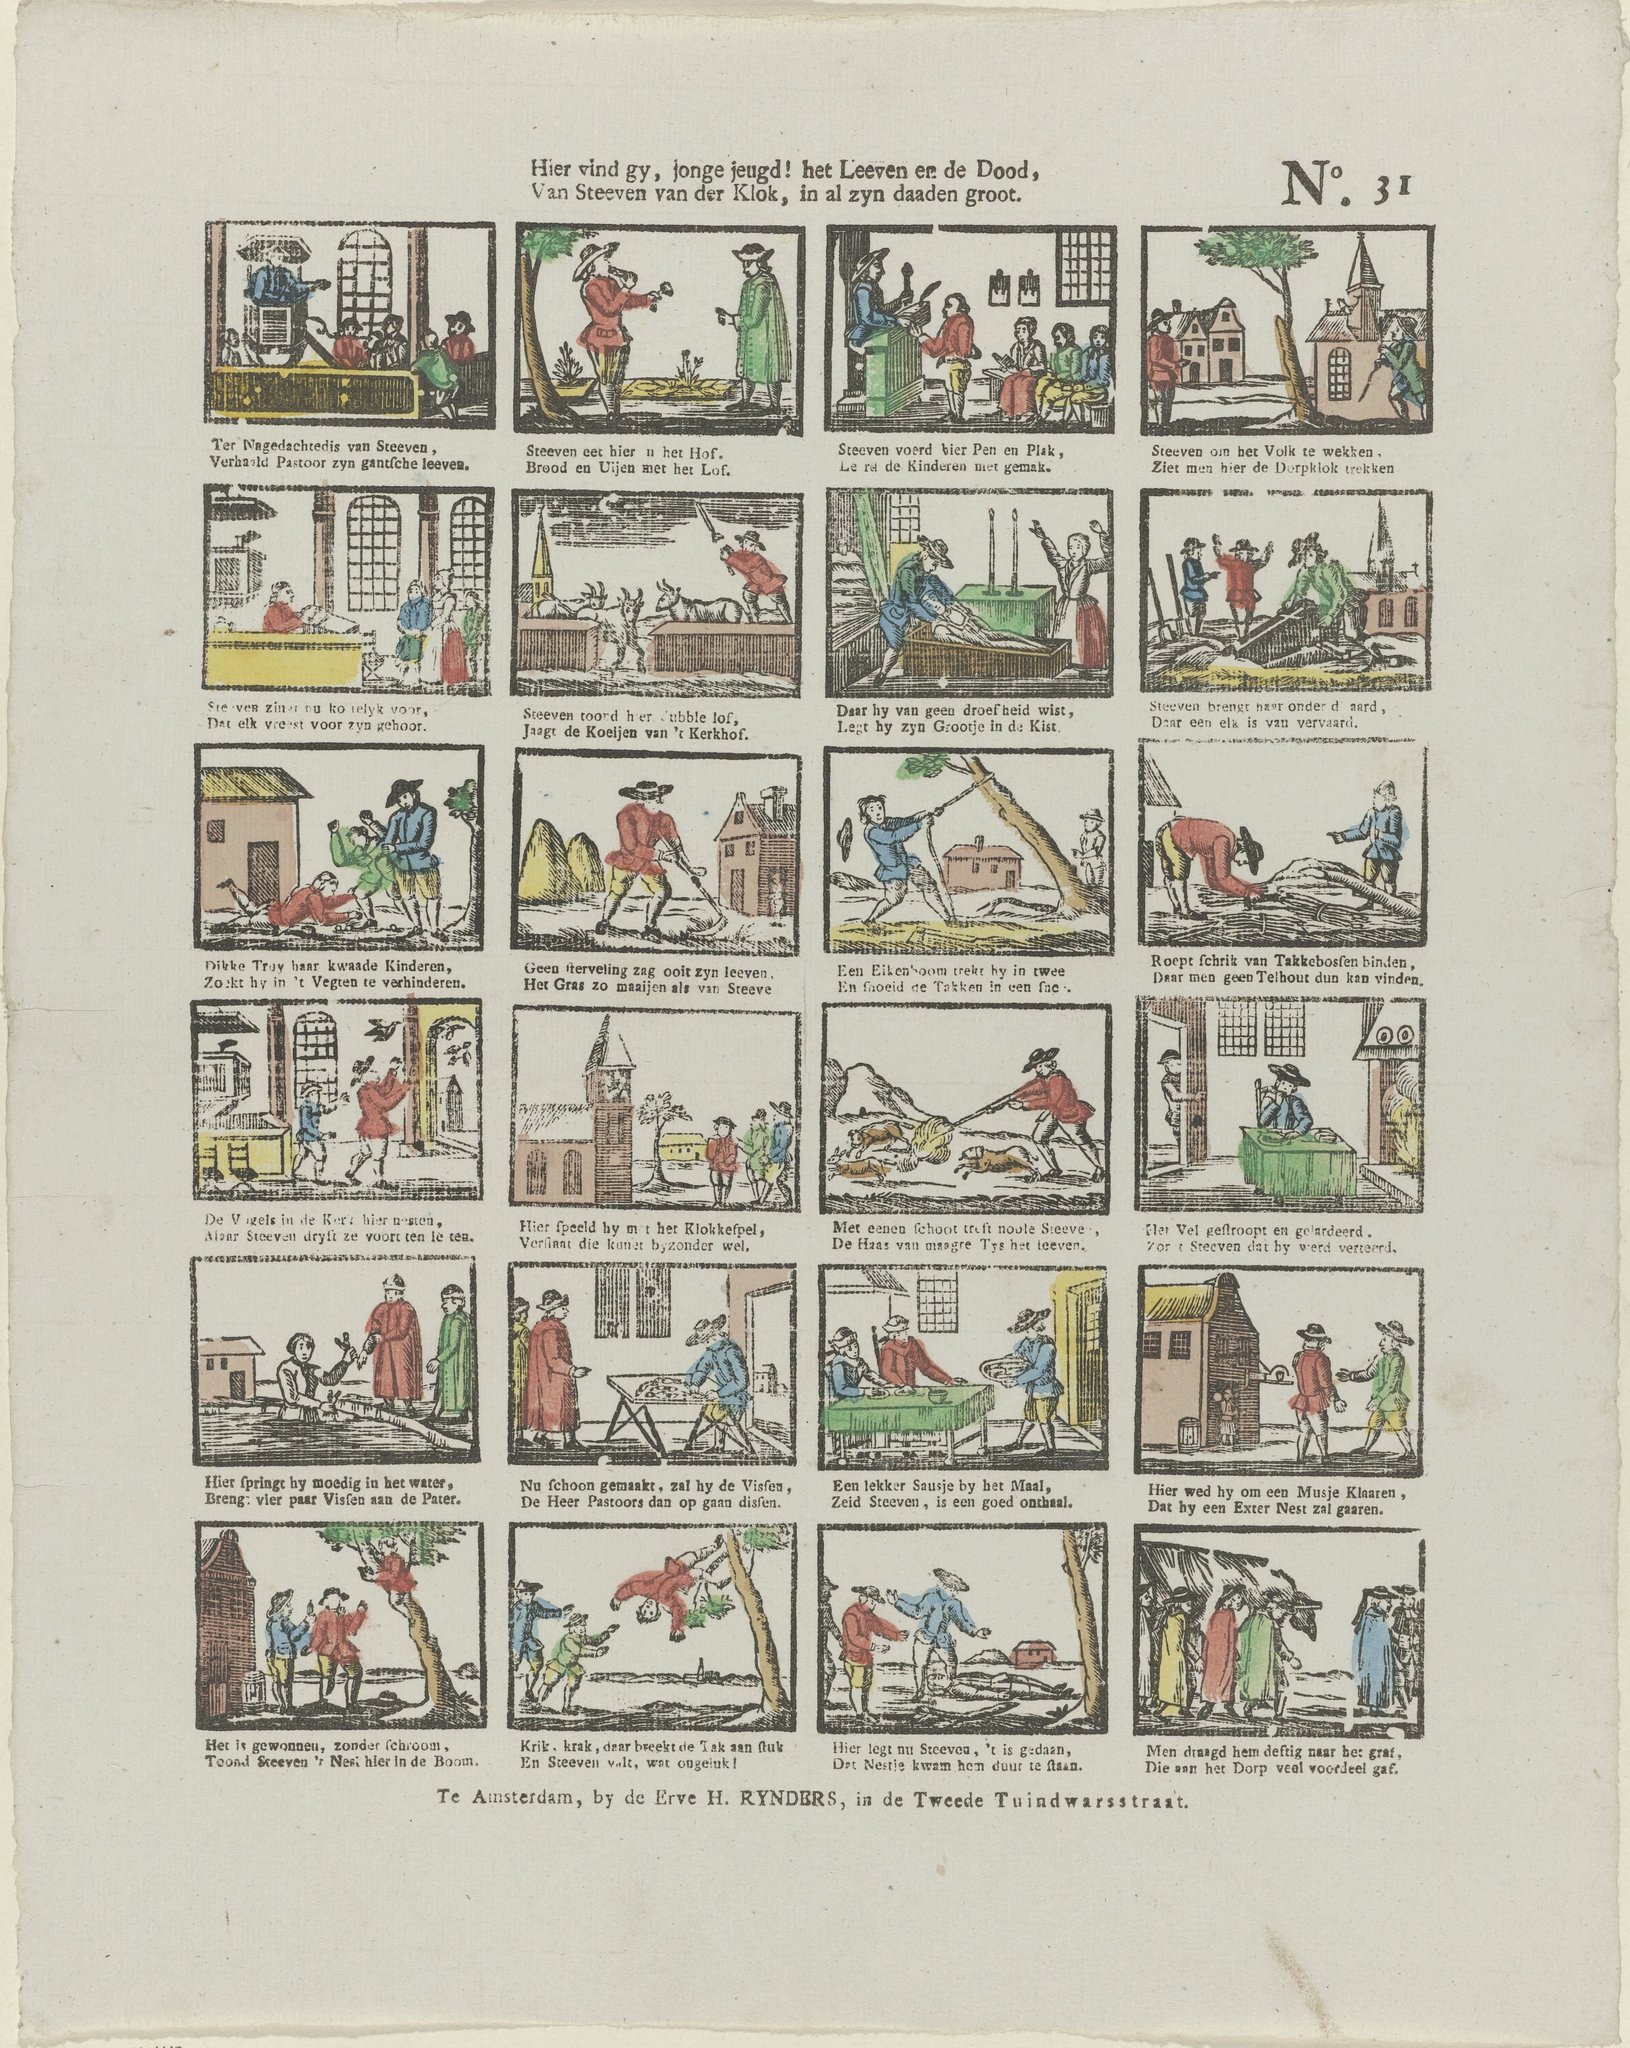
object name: print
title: Hier vind gy, jonge jeugd! het leeven en de dood, / Van Steeven van der Klok, in al zyn daaden groot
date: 1831-1854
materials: paper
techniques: colour, letterpress printing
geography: amsterdam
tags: death by accident (non-violent death), funerary ceremonial, tales and fairy tales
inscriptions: collector's mark: Lugt 2760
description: Blad met 24 voorstellingen over het leven van Steven van der Klok. Onder elke afbeelding een tweeregelig vers. Genummerd rechtsboven: No. 31.